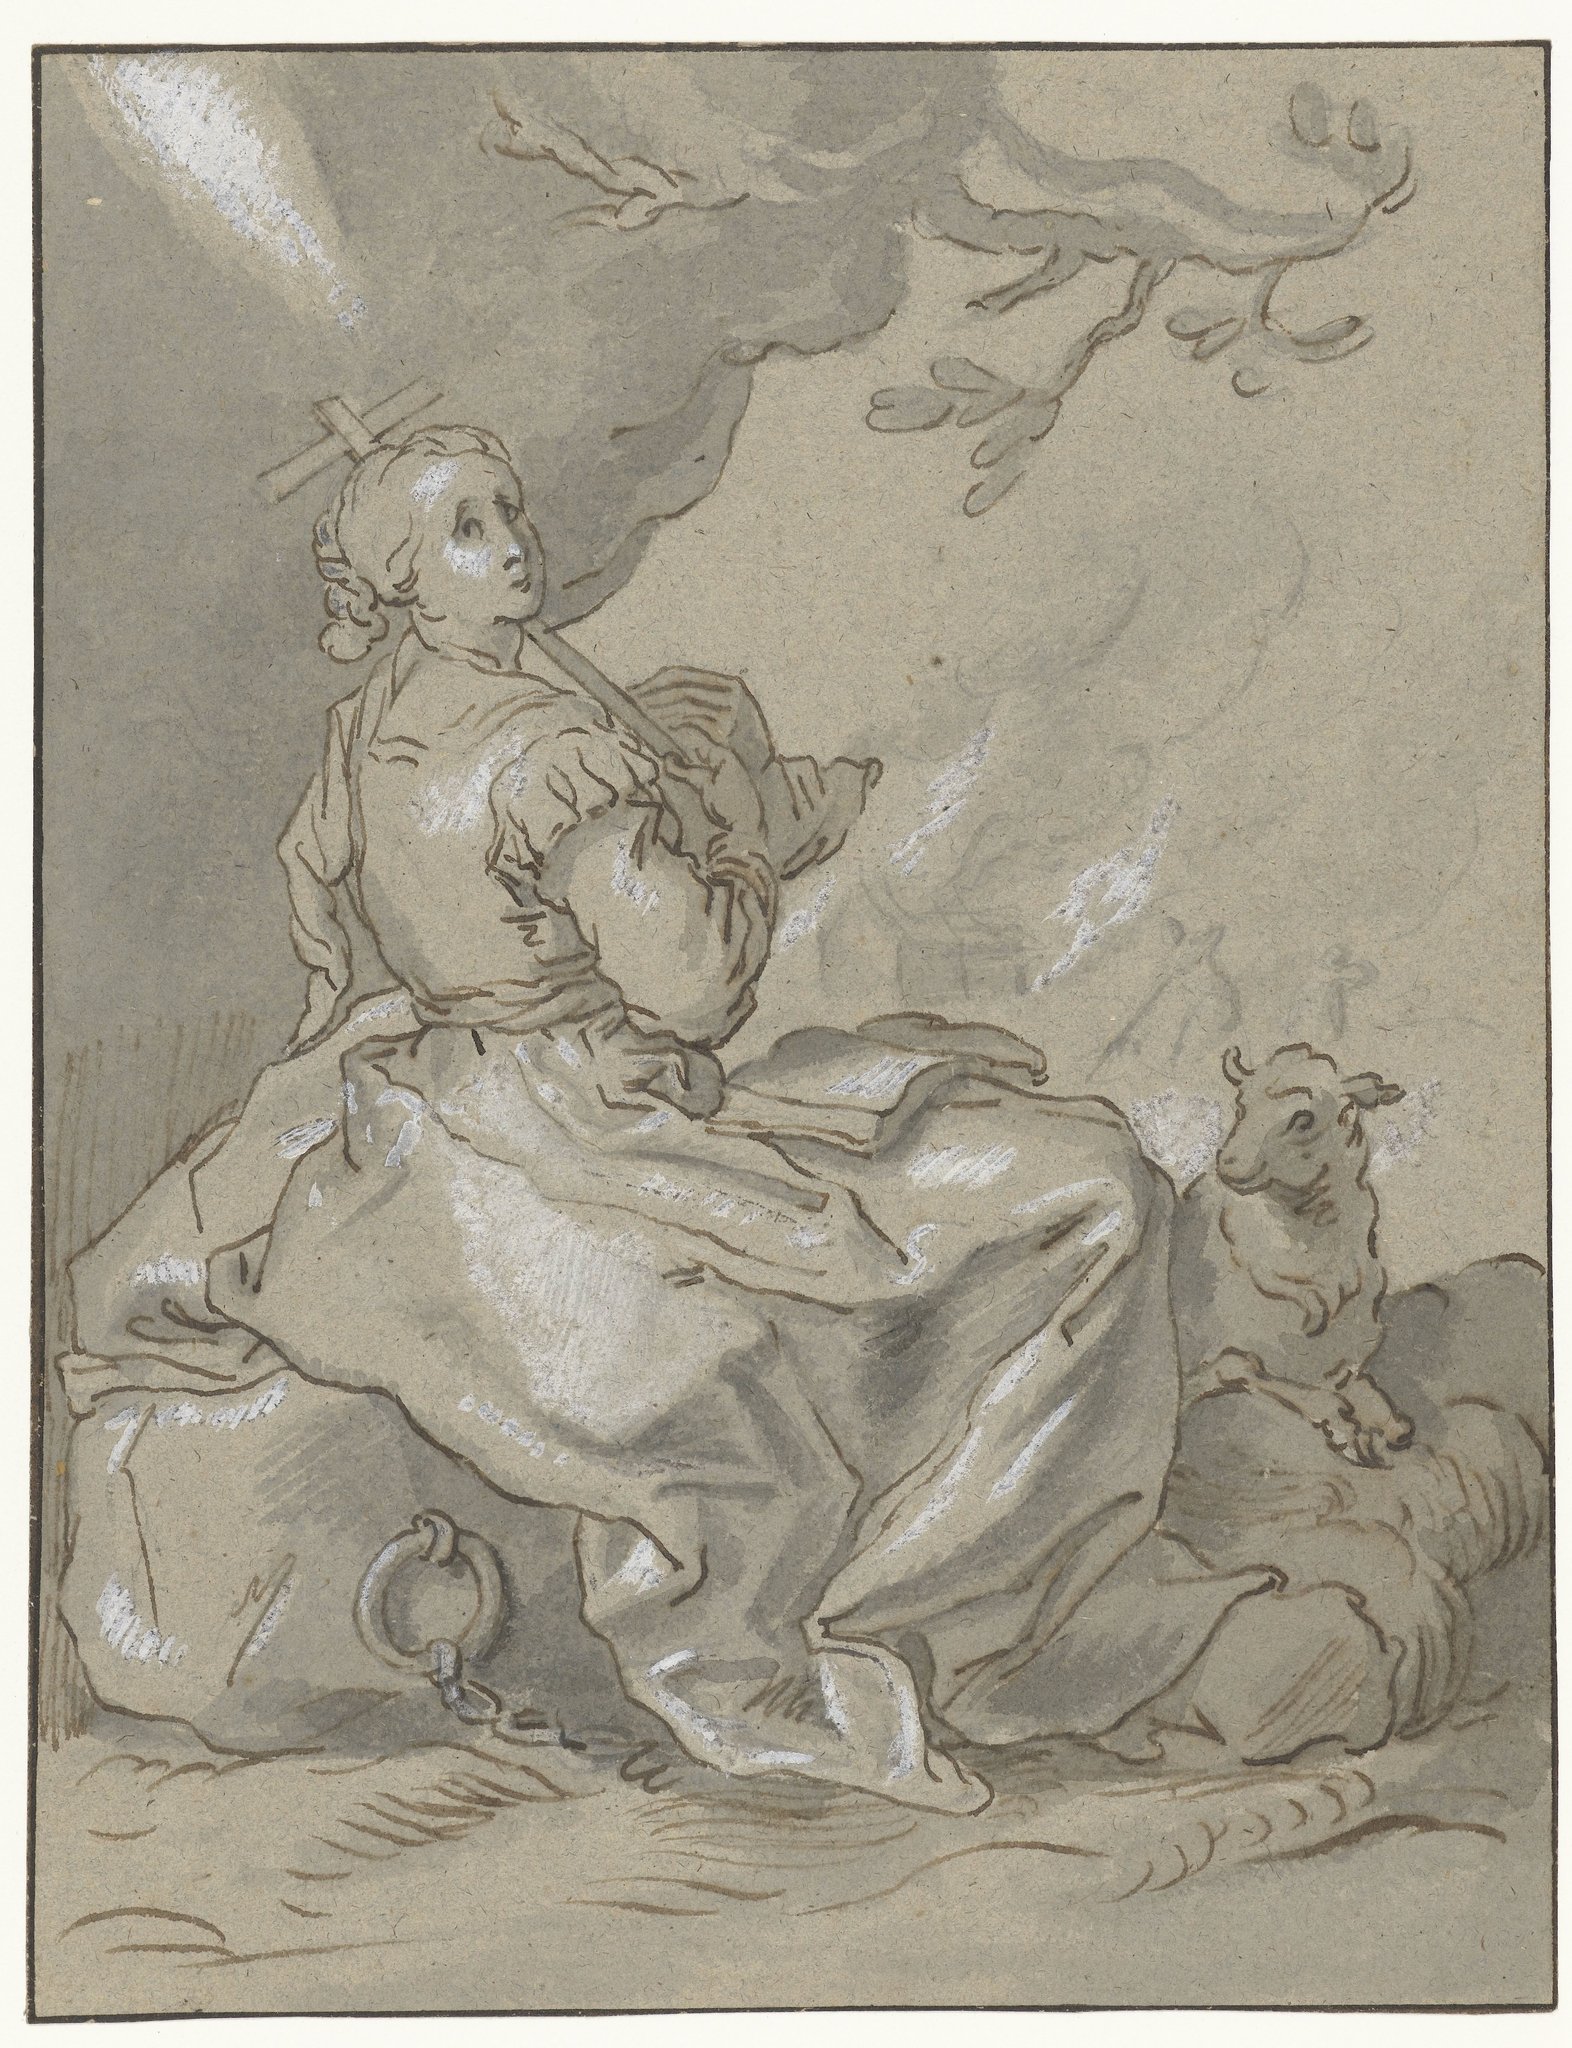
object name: drawing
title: Heilige Agnes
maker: Anonymous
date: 1574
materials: ink, paint, paper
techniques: brush, pen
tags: the virgin martyr agnes of rome; possible attributes: lamb, ring